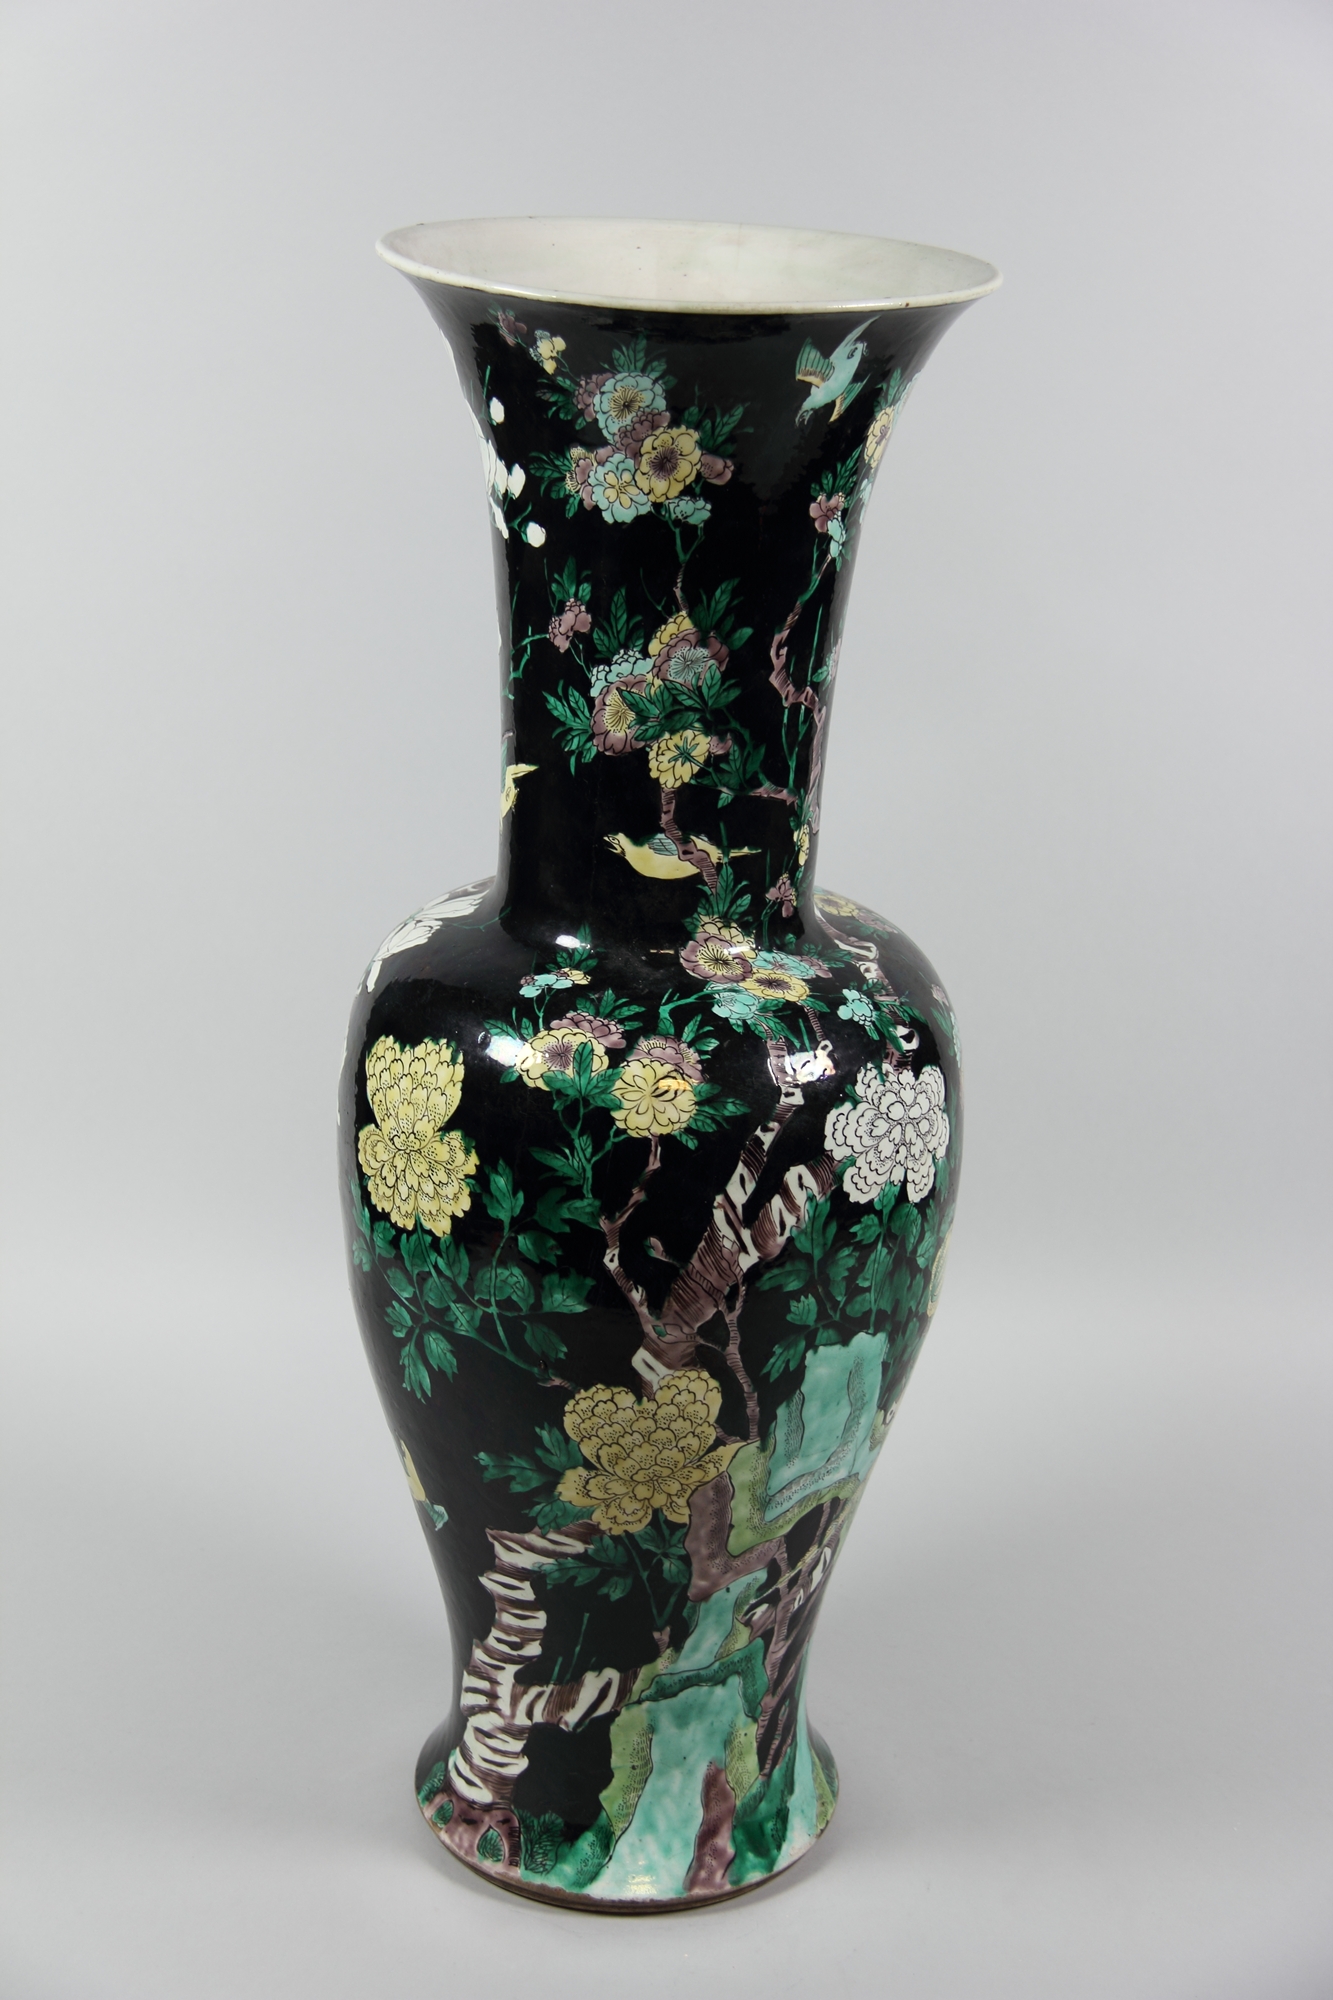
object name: vase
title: Vase with birds and flowers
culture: chinese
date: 1801-1900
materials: enamel, porcelain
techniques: painting, polychrome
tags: birds,flowers